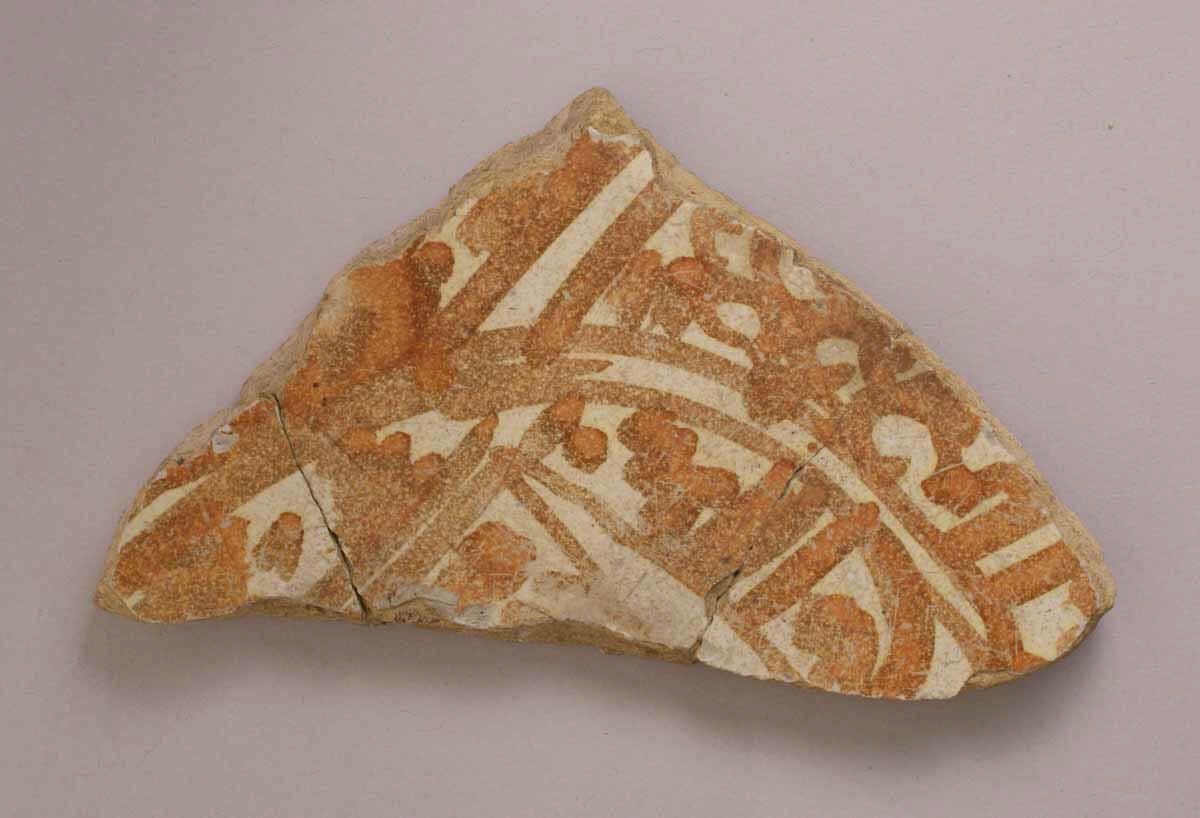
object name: fragment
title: Ceramic Fragment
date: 1101-1200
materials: earthenware, tin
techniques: enamel, luster painting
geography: egypt